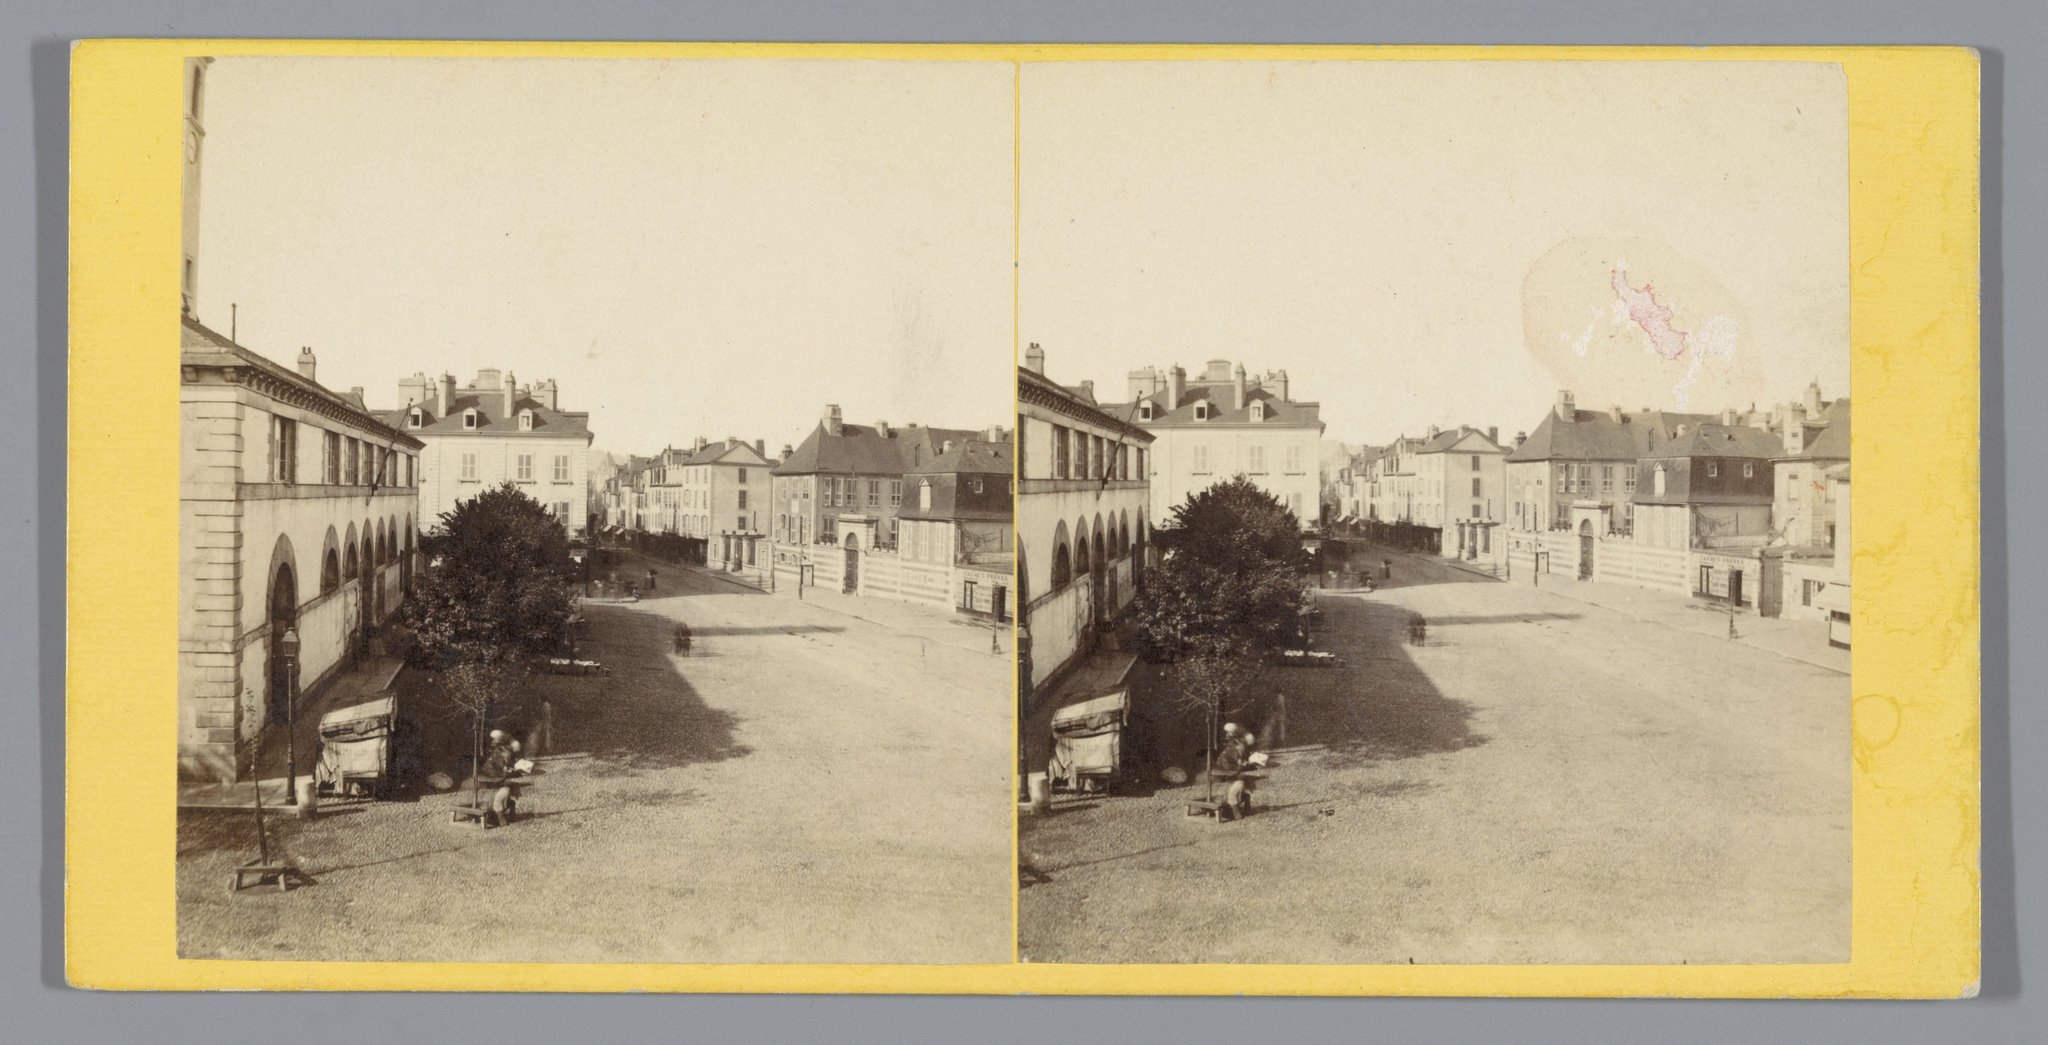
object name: stereograph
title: Gezicht op een plein in Pau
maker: Anonymous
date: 1850-1880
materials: cardboard, photographic support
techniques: albumen print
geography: pau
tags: square, place, circus, etc.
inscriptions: inscription: ‘et Préfecture’, number: ‘173.’